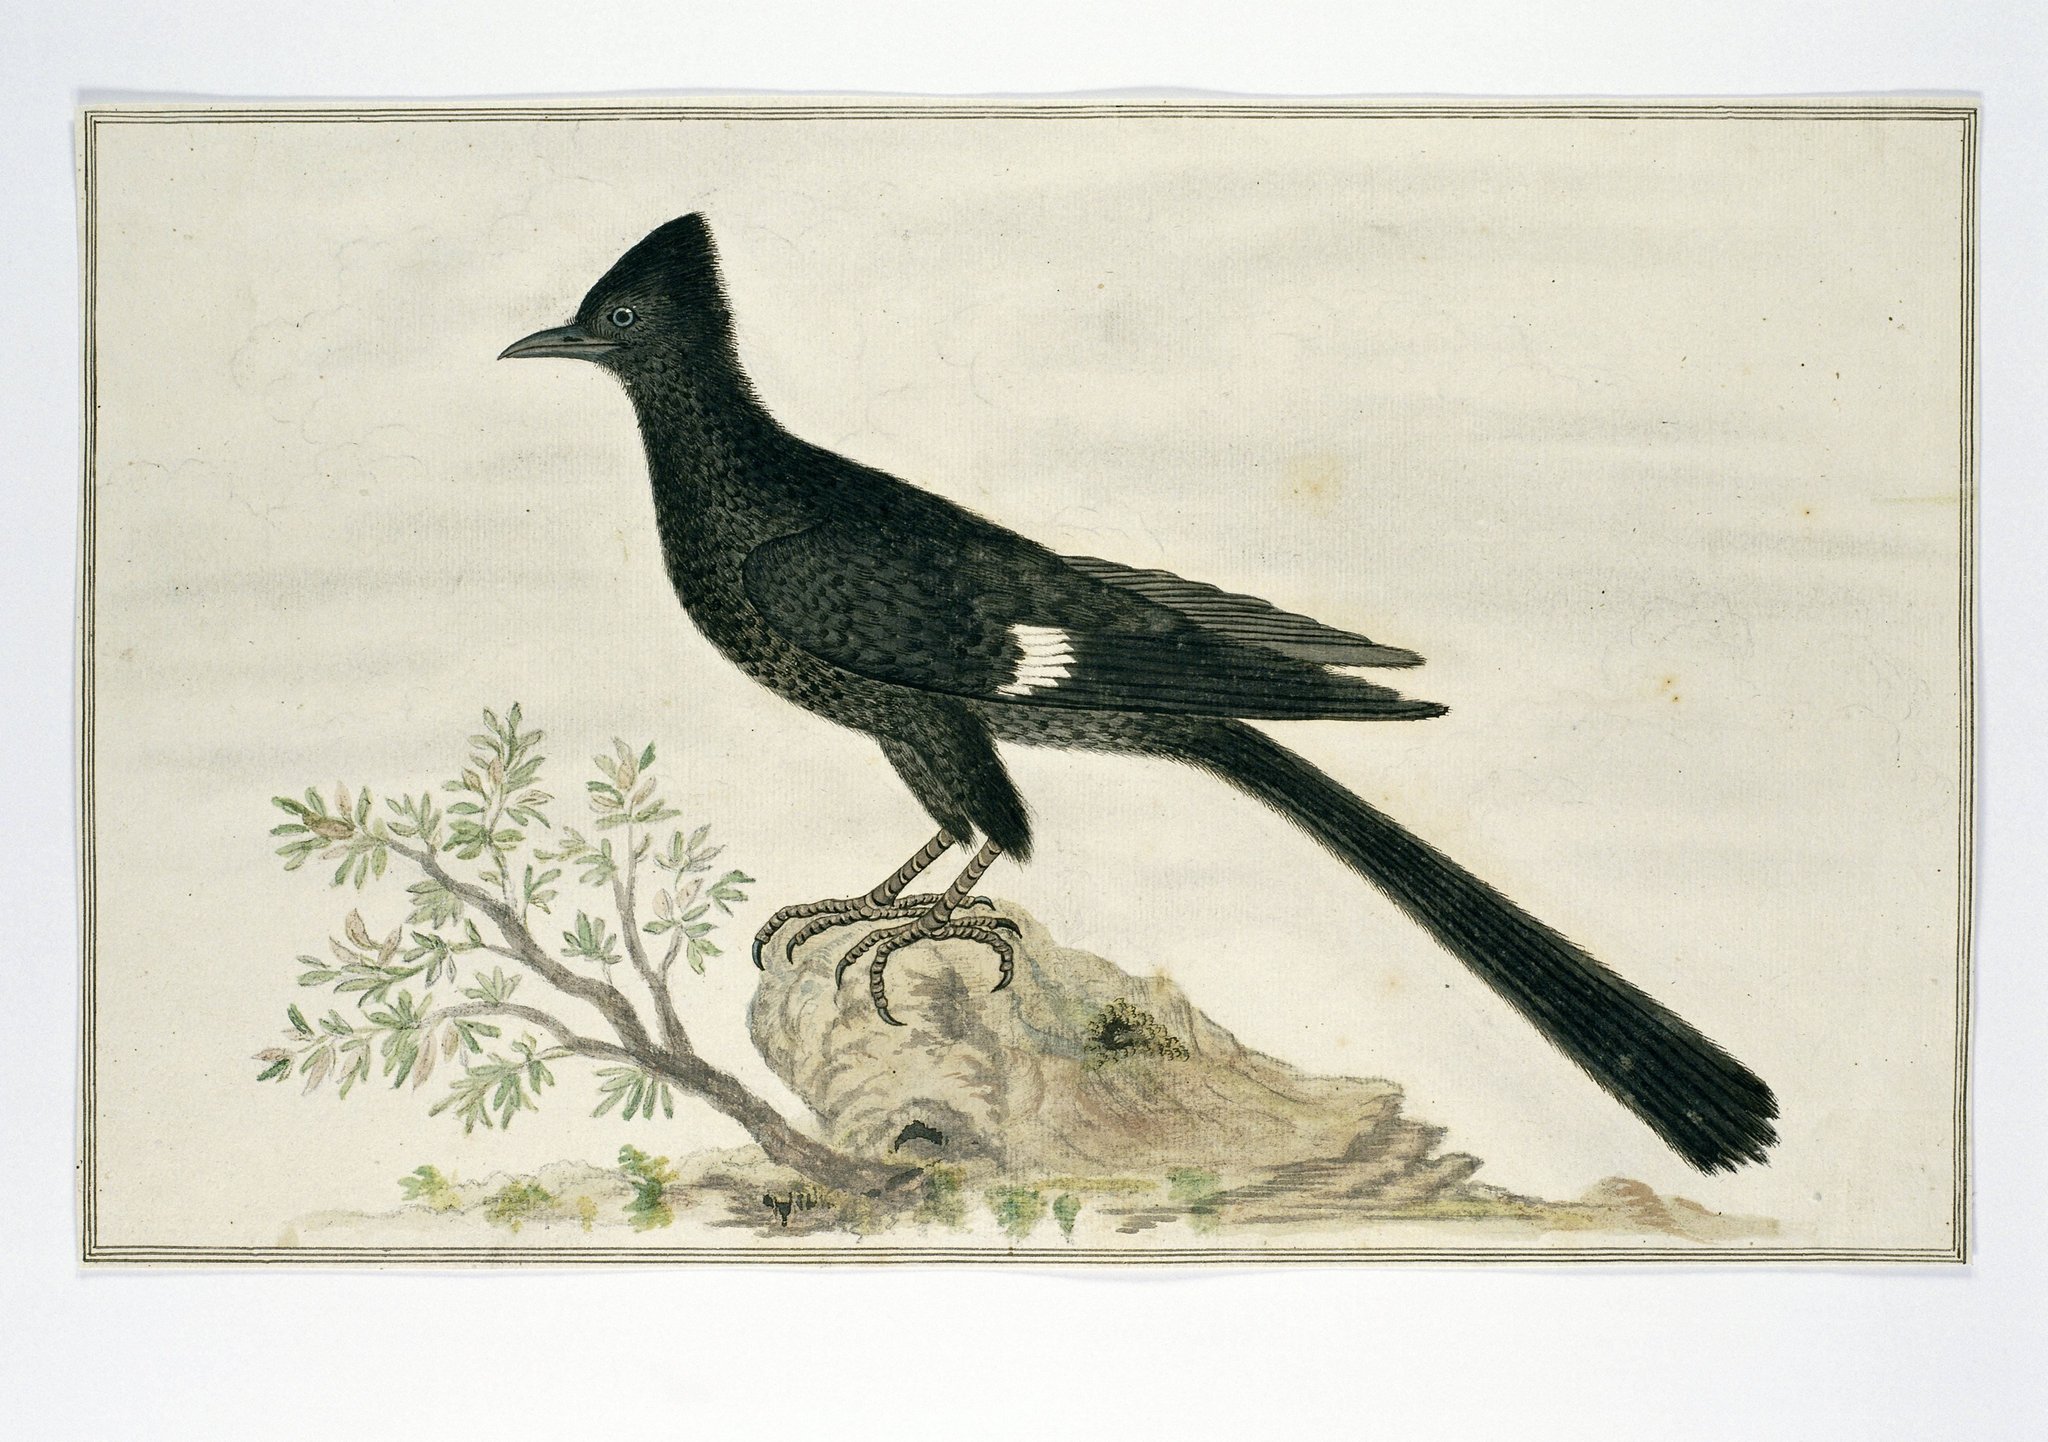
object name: drawing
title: Clamator jacobinus (Jacobin cuckoo)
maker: robert jacob gordon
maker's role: draughtsman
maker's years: 1743-1795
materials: chalk, paint, ink, paper, pencil, watercolor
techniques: brush, pen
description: de vogel is vrijwel identiek aan G. 292. Jacobin cuckoo (Eng.)